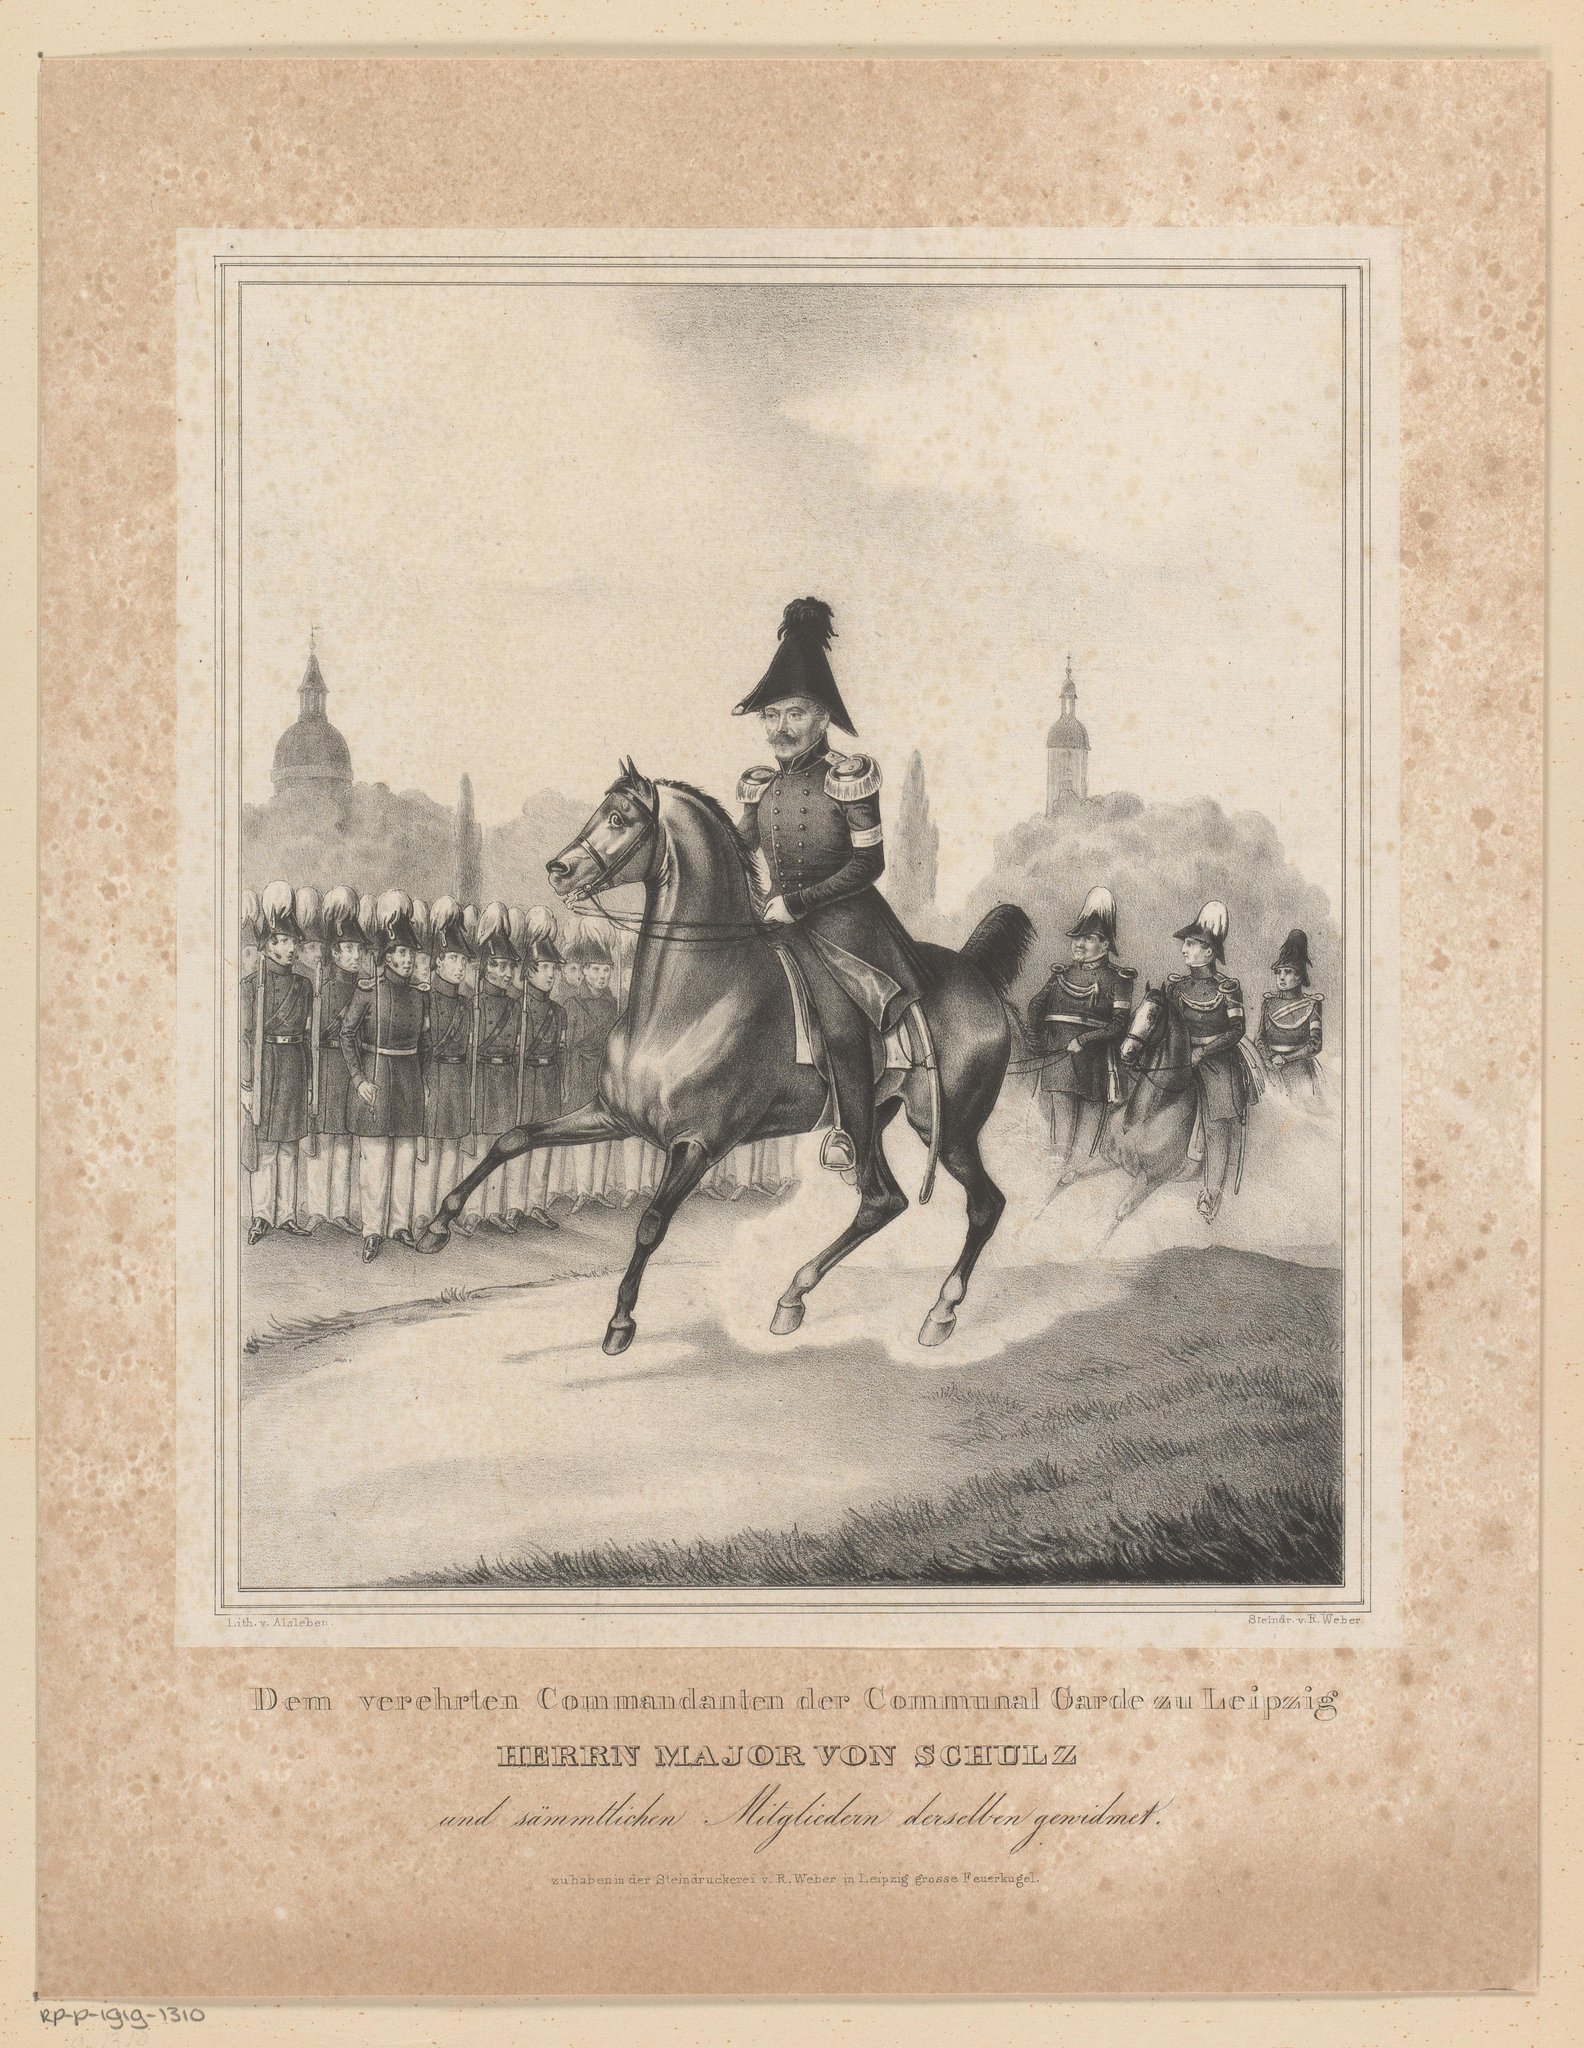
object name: print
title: Portret van de majoor von Schulz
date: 1798-1899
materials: paper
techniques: lithograph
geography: leipzig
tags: historical persons, officer (with name of rank)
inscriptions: collector's mark: Lugt 2228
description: Met drieregelig onderschrift in het Duits.